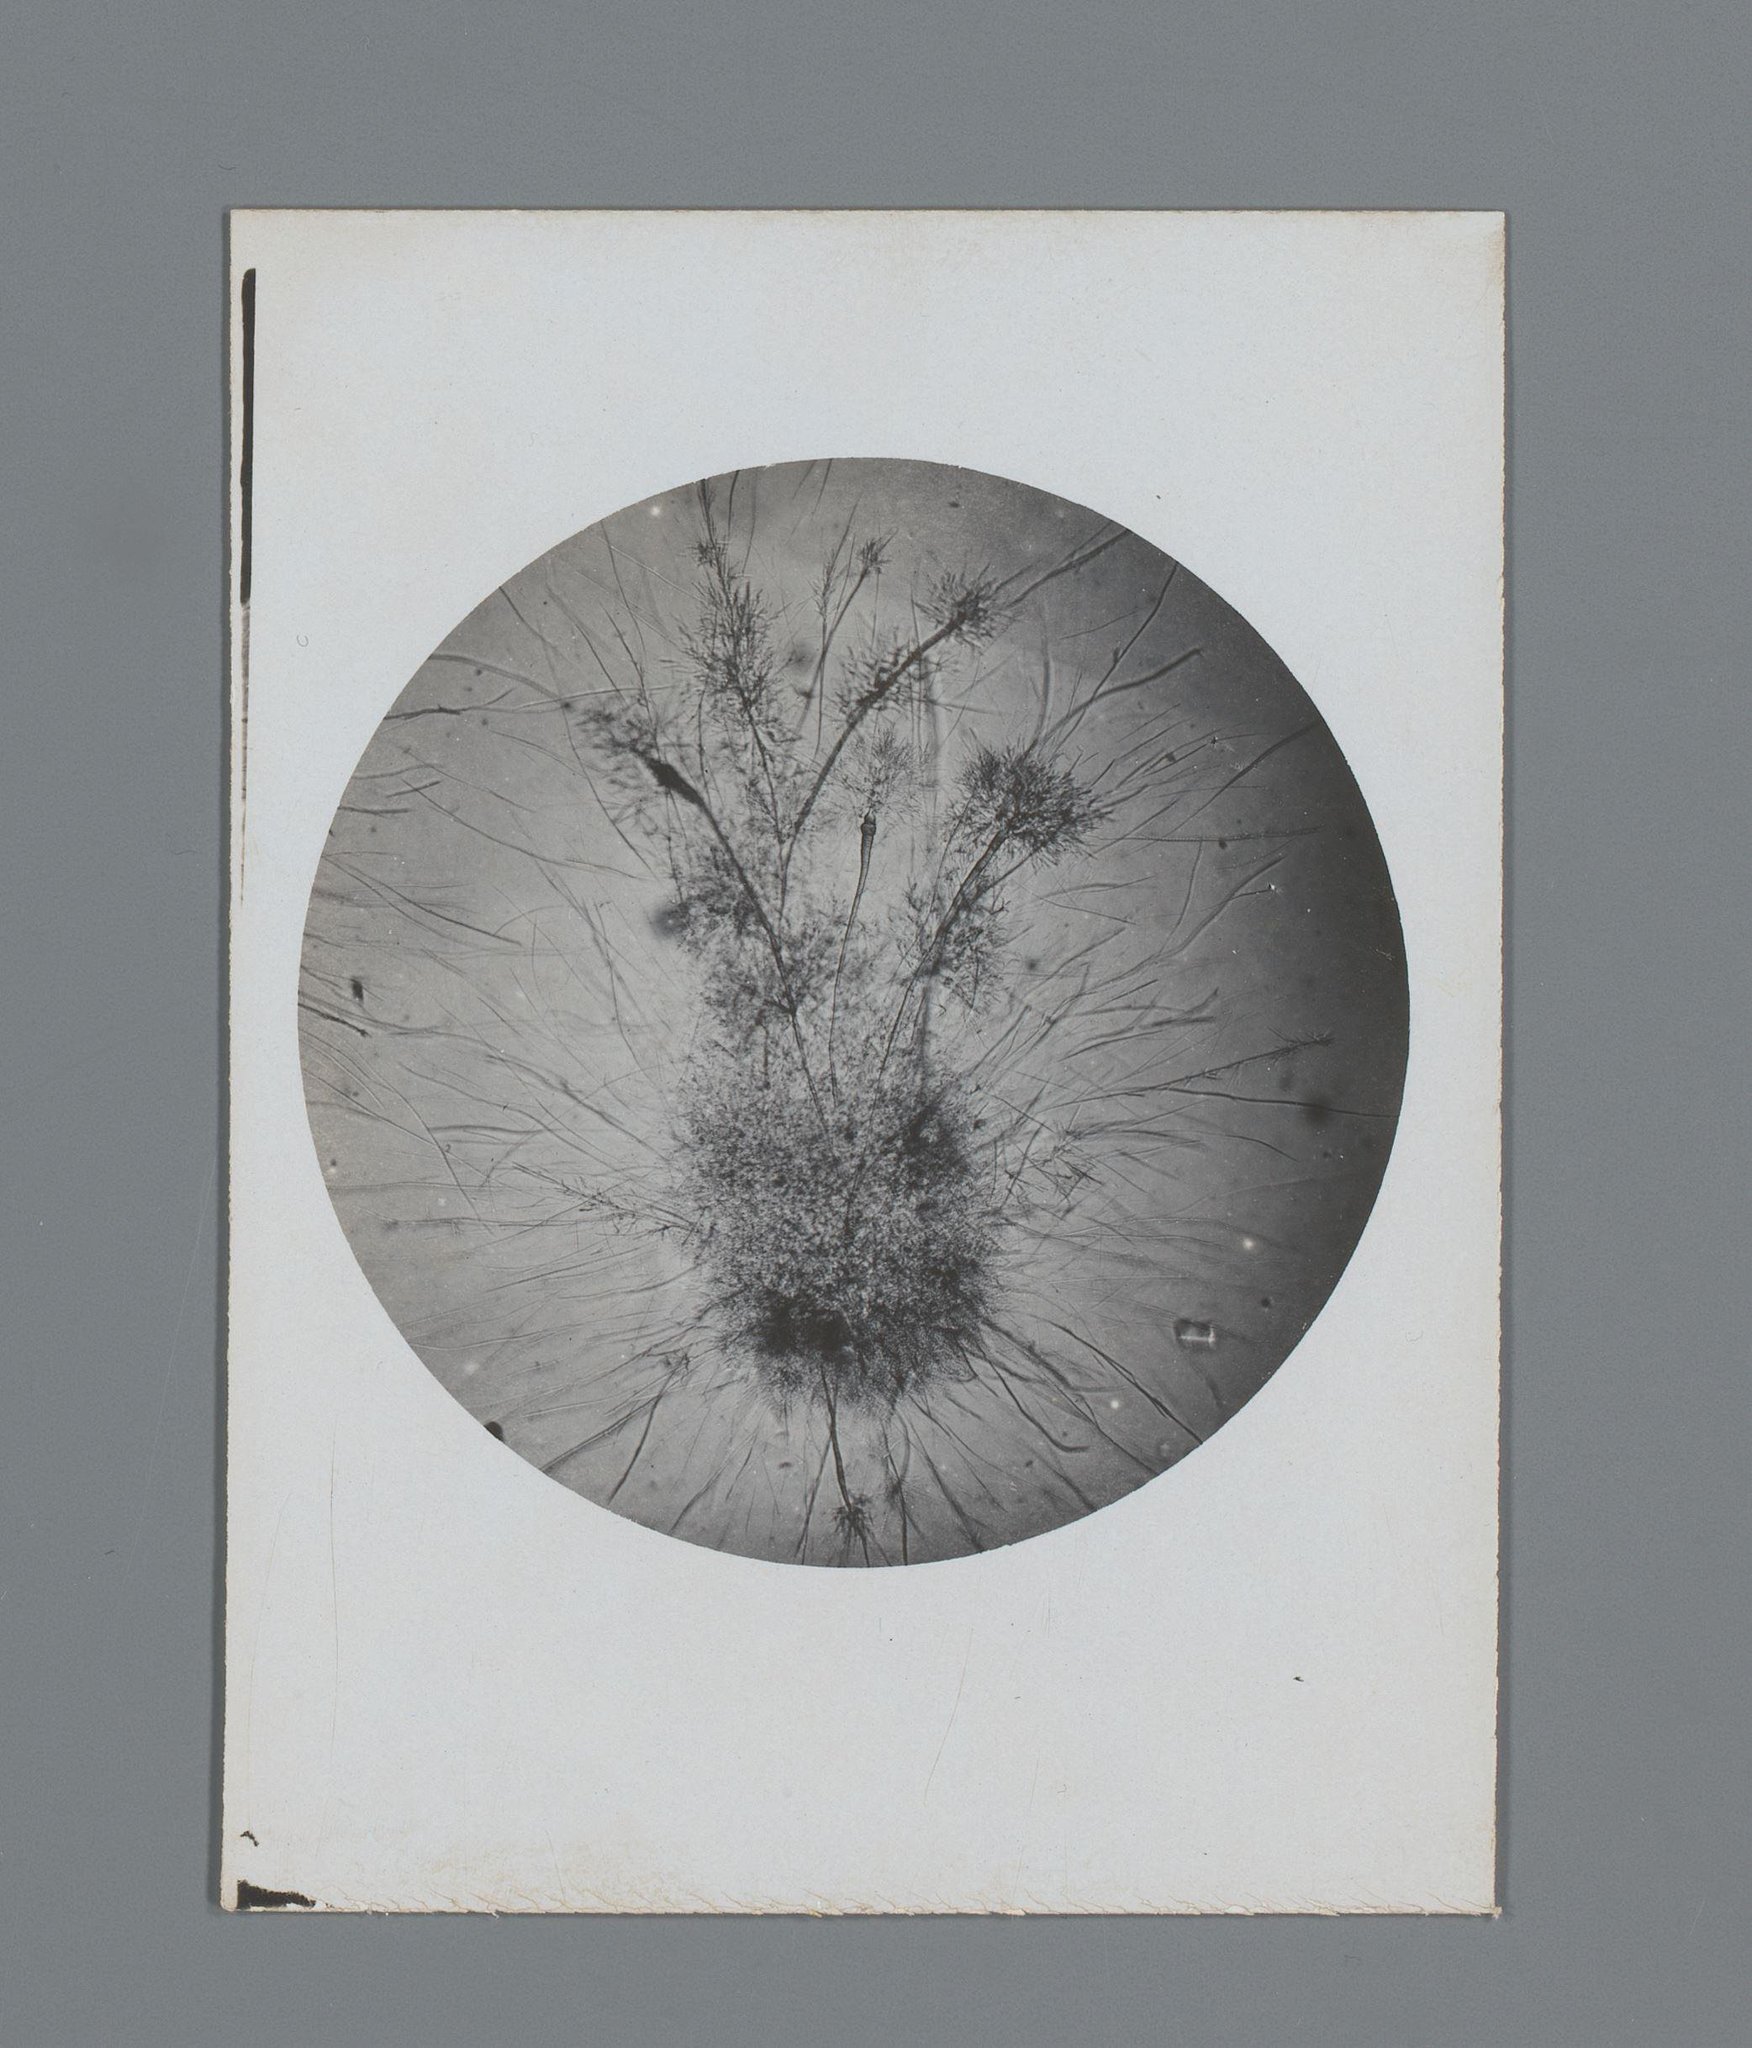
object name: photograph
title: Opname van een microscopisch preparaat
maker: Anonymous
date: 1880-1910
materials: paper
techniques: gelatin silver print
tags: unicellular animals, bacteria, bacilli